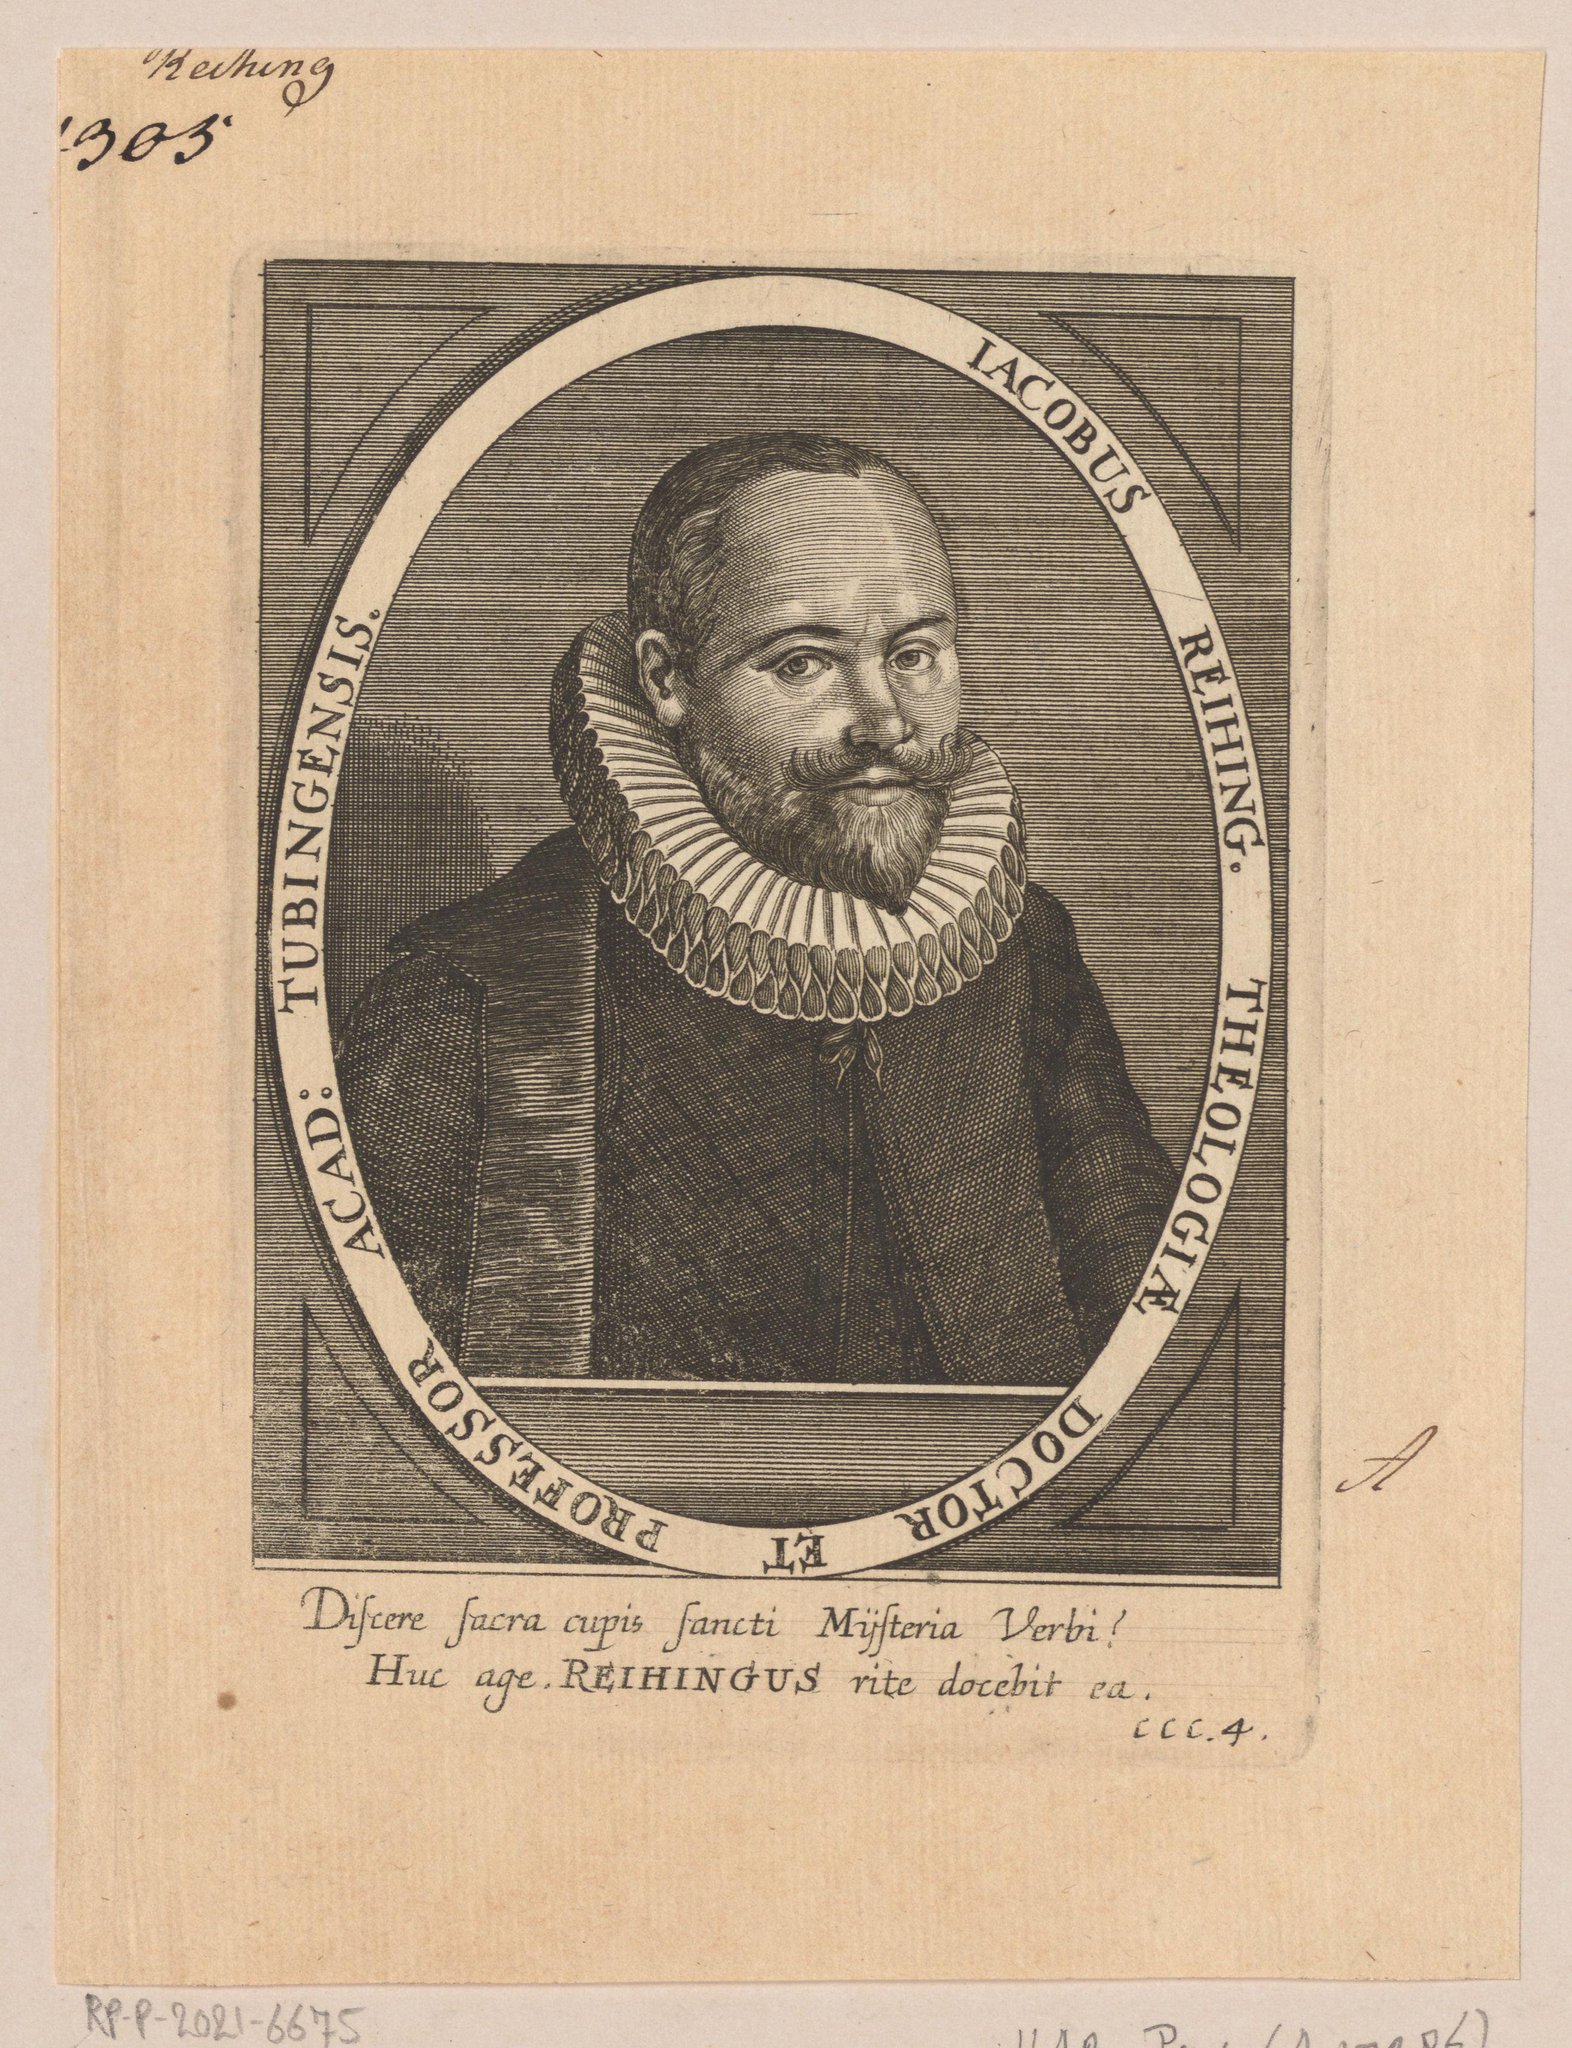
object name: print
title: Portret van Jacob Reihing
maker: clemens ammon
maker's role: print maker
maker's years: 1627-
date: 1652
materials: paper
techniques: engraving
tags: historical persons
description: Prent waarschijnlijk uit: Boissard, Jean Jacques. Bibliotheca chalcographica (...). Frankfurt am Main: Johannes Ammon, 1652, dl. 7.